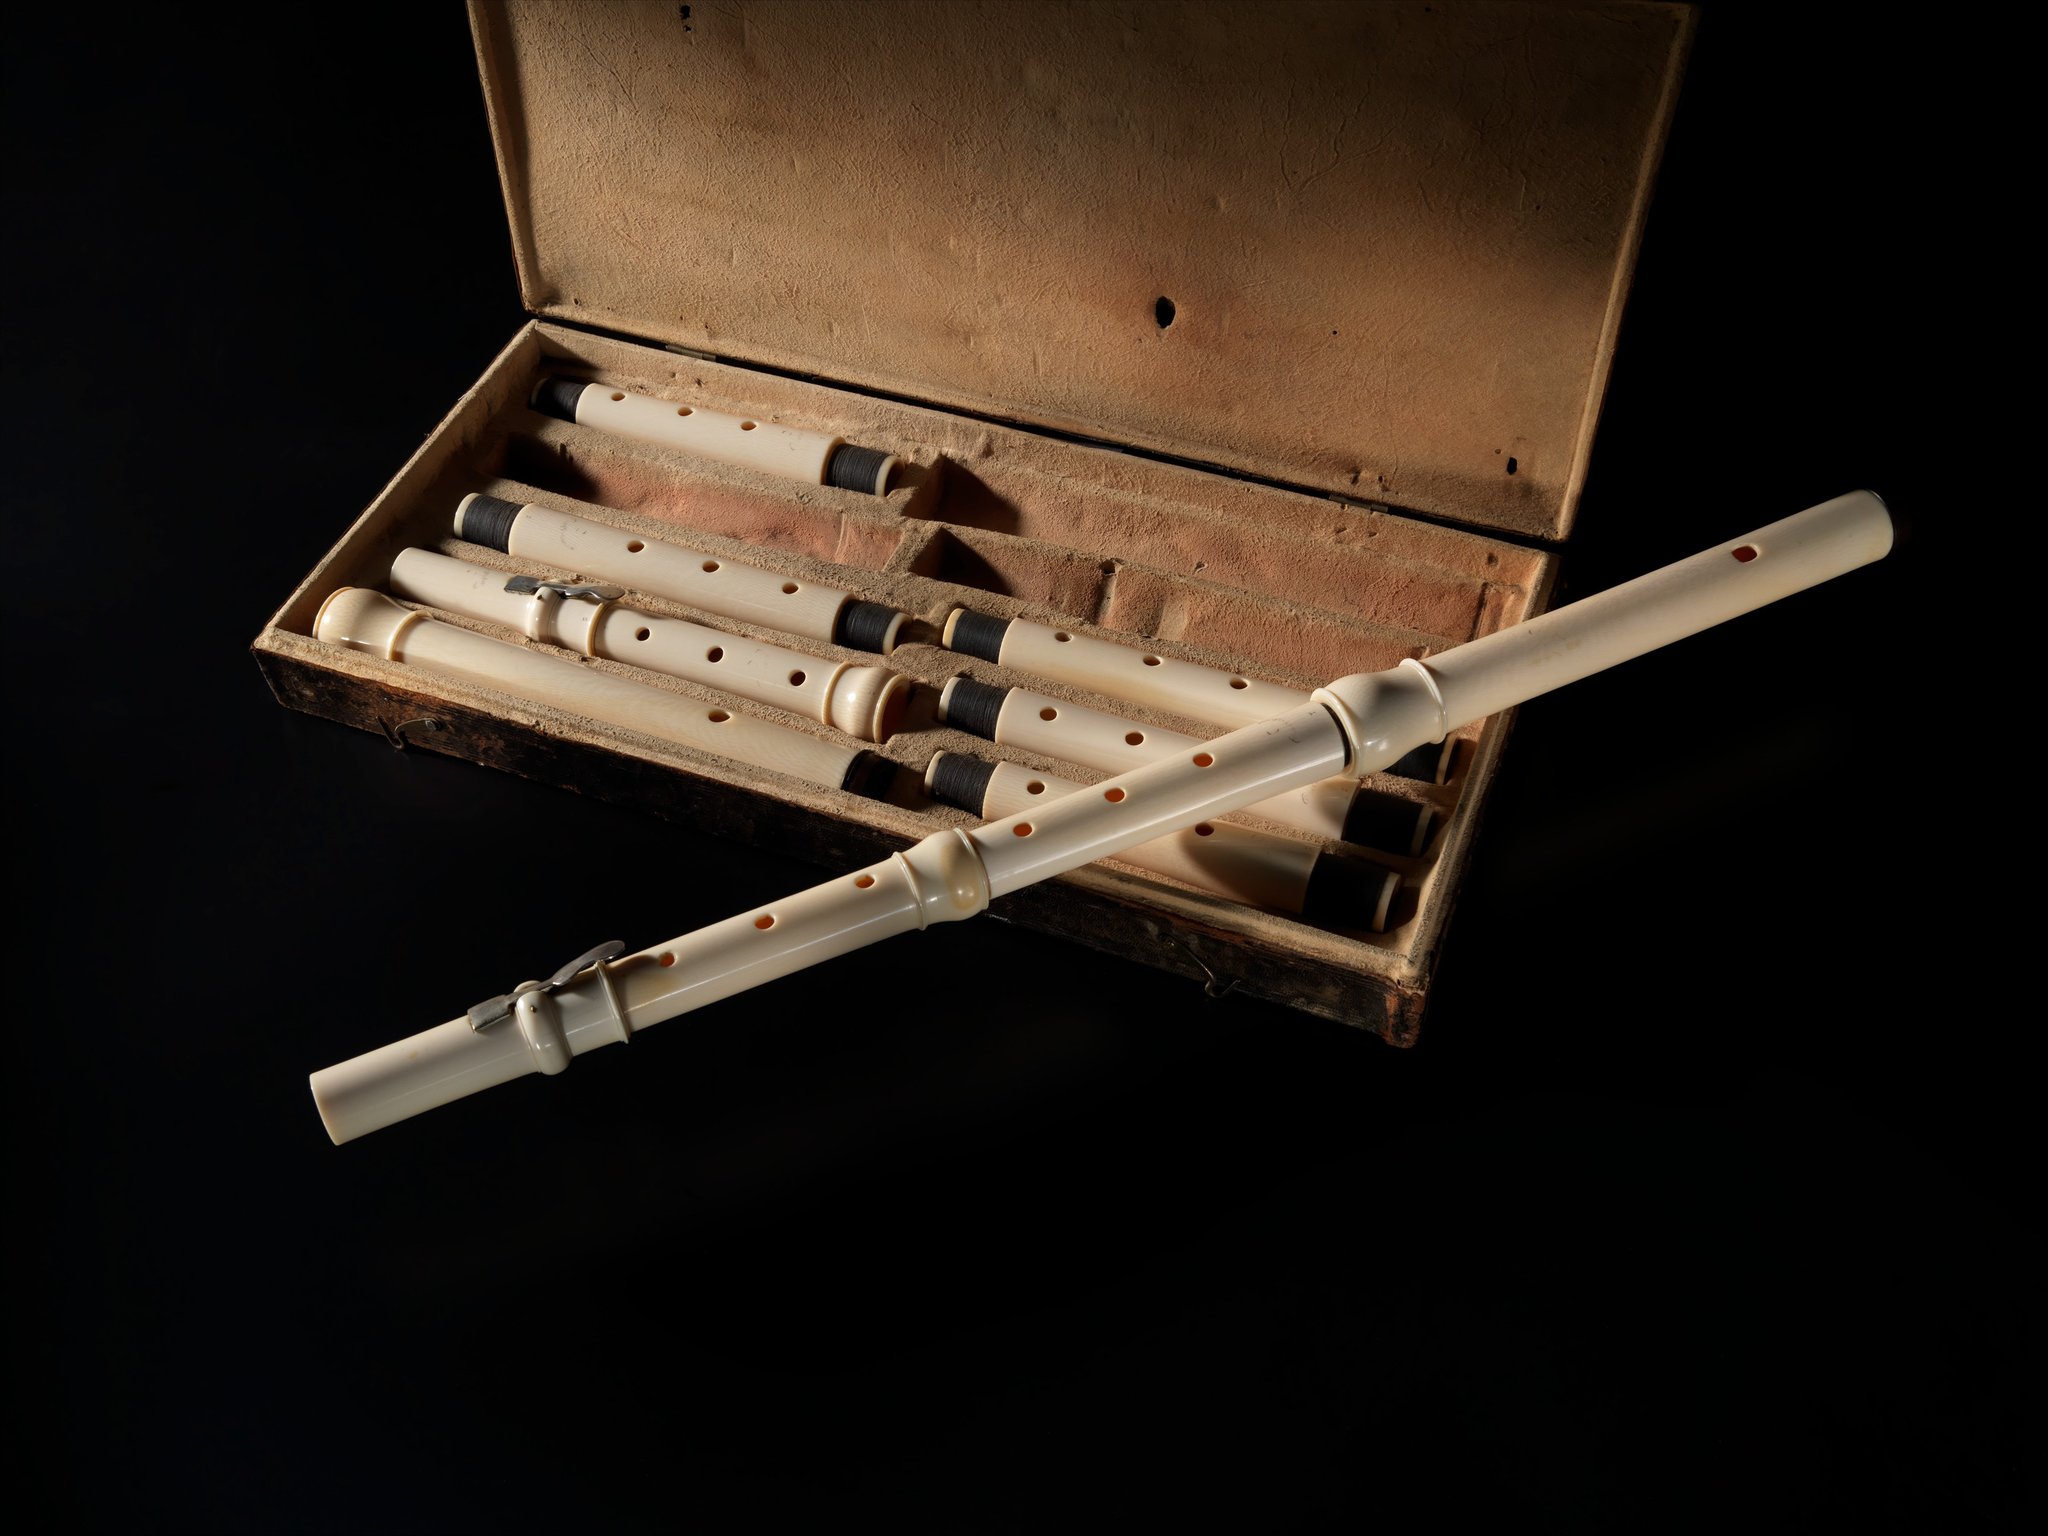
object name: pair of transverse flute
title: Pair of Transverse Flutes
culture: german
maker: johann wilhelm oberlender (the elder)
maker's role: maker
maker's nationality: german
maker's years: 1681-1763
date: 1734-1766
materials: ivory, silver, wood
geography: germany